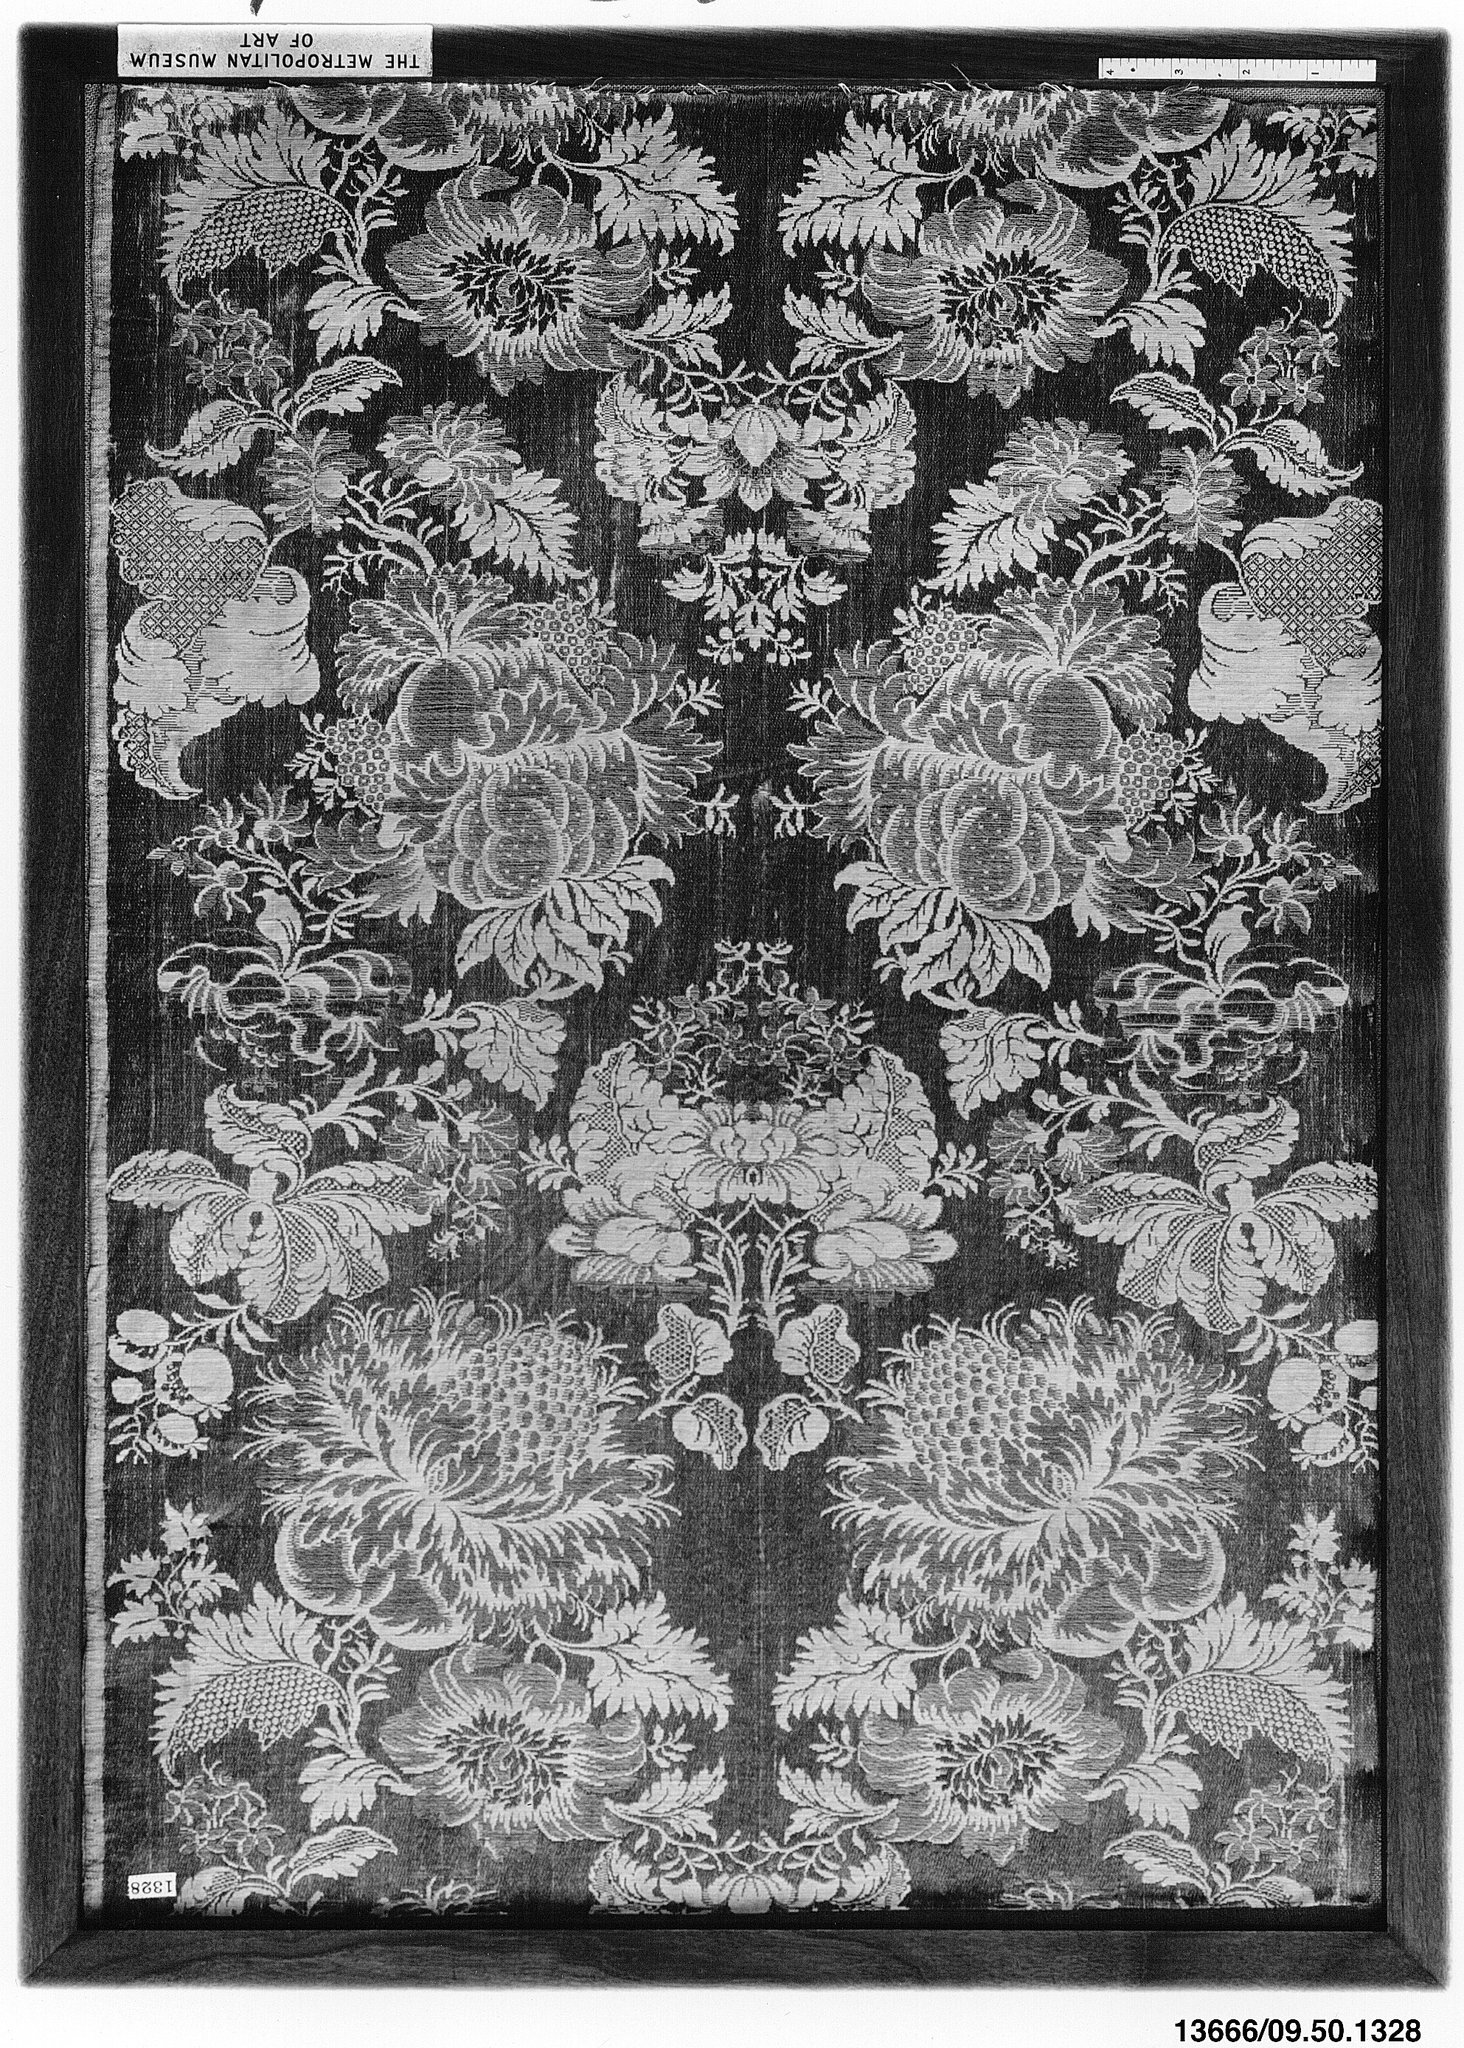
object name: piece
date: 1730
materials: silk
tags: flowers,leaves